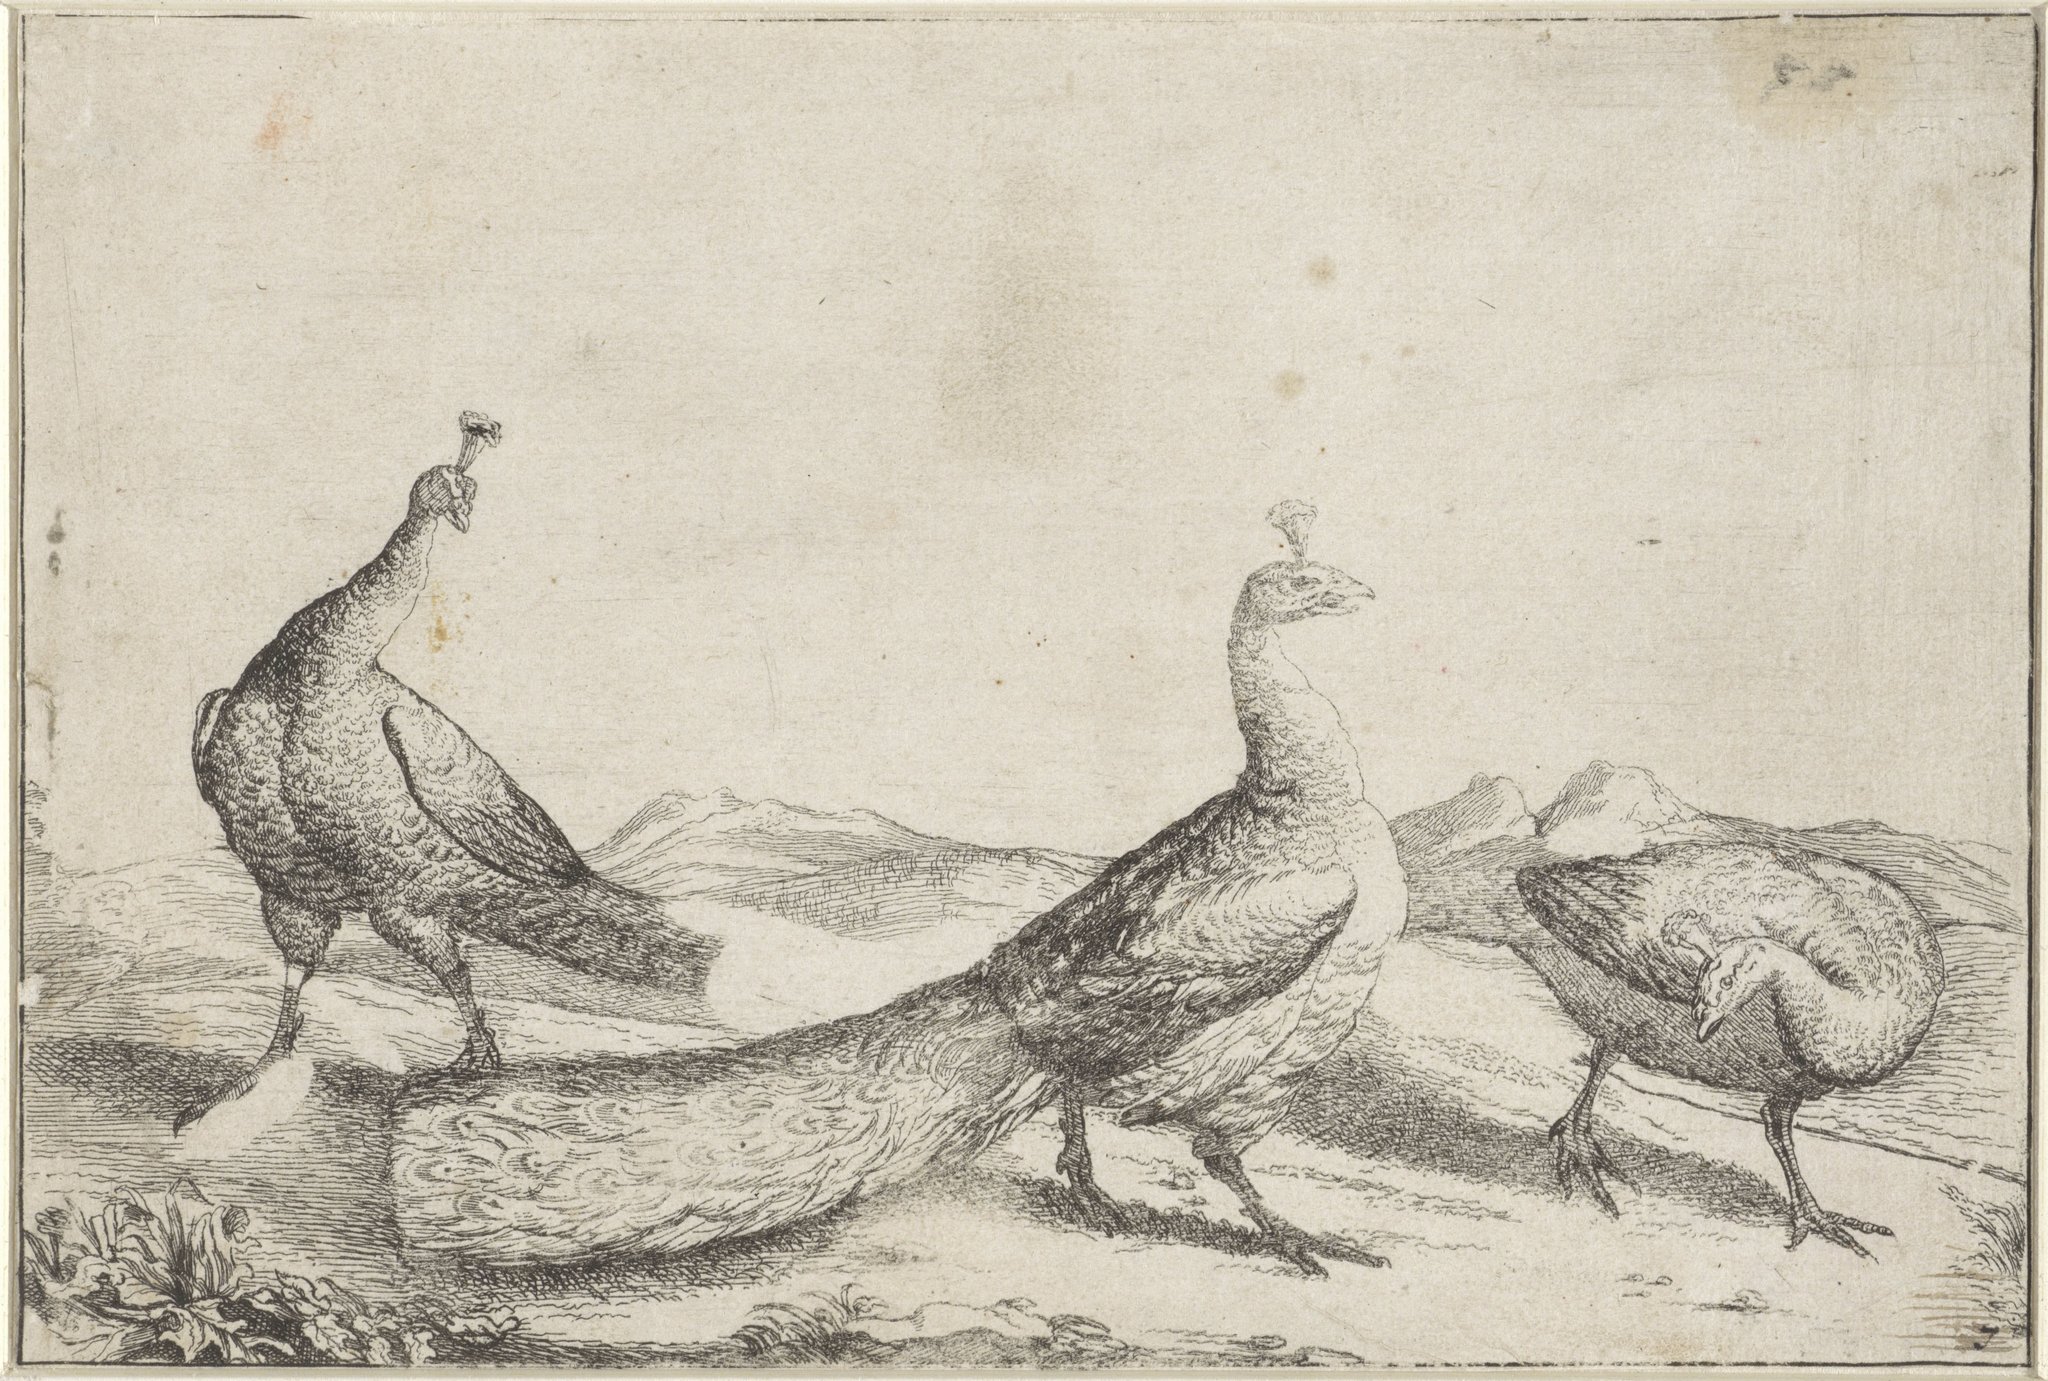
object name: print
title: Drie pauwen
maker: Anonymous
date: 1654-1750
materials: paper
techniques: etching, pen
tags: ornamental birds: peacock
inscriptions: collector's mark: Lugt 240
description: Vgl. serie "Diversae avium species", door Wenceslaus Hollar.